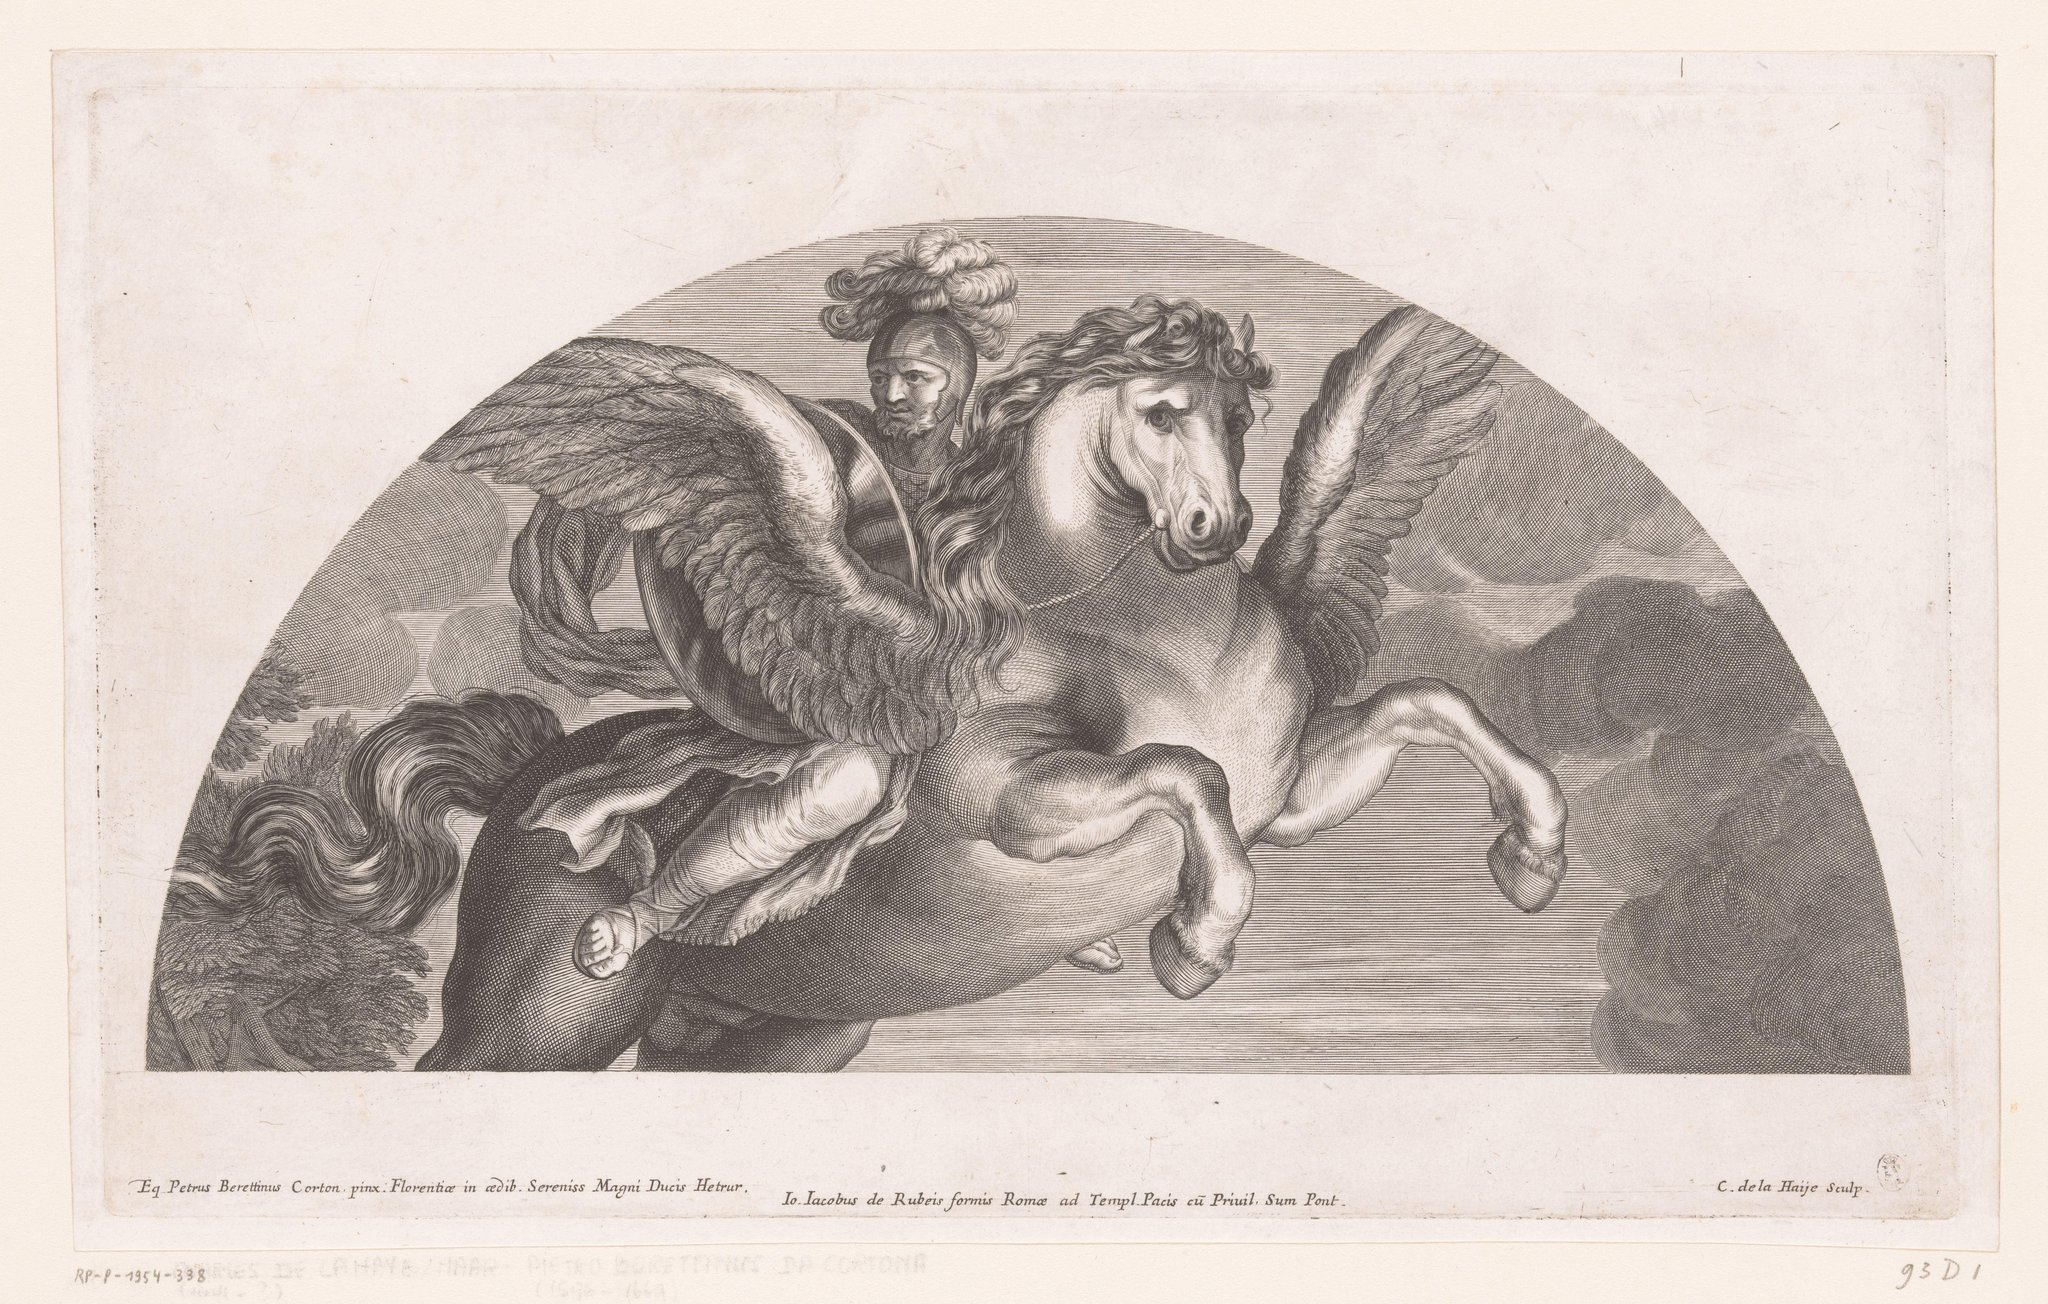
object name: print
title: Perseus op Pegasus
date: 1651-1691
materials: paper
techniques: engraving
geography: france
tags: pegasus, the winged horse, (story of) perseus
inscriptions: collector's mark: Lugt 971